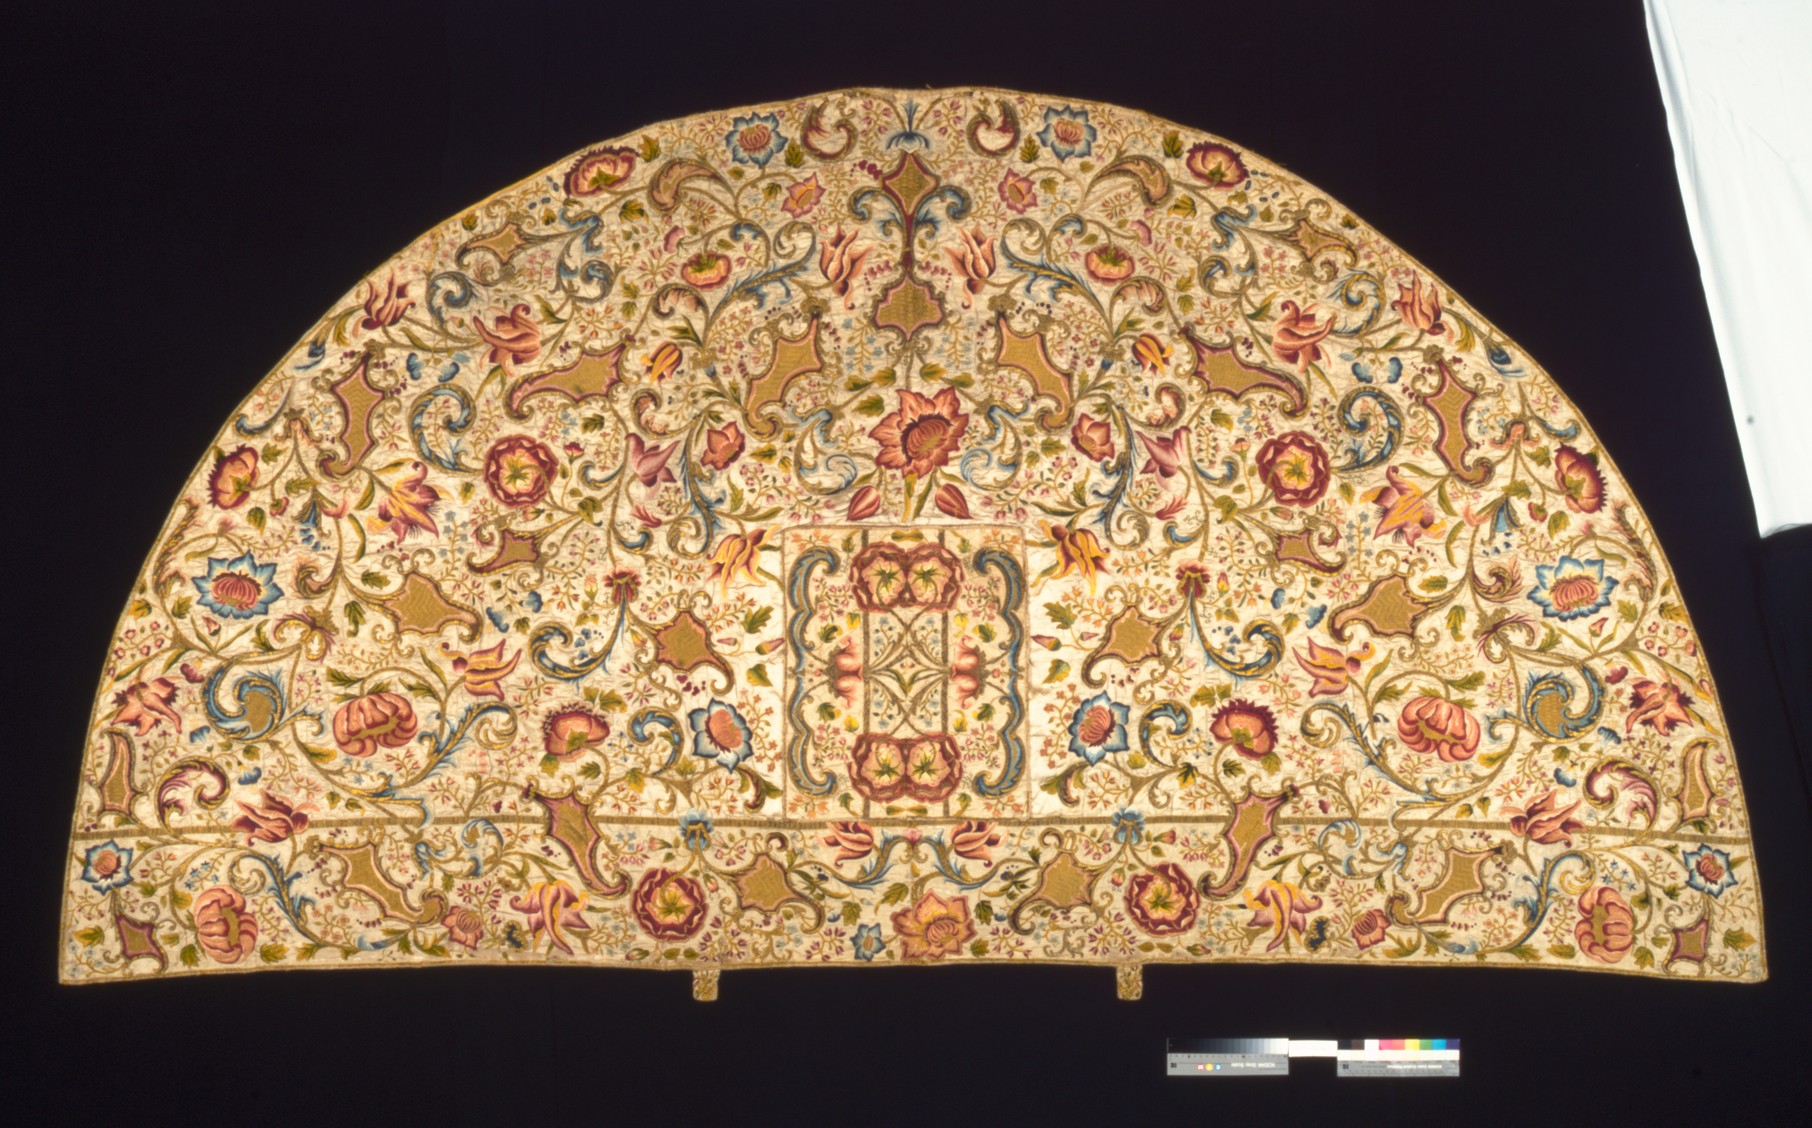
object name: cope with hood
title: Cope with a Hood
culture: italian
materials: gilt, linen, metal, textile, silk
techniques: embroidery, laid work, weave, satin weave, stitching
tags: flowers